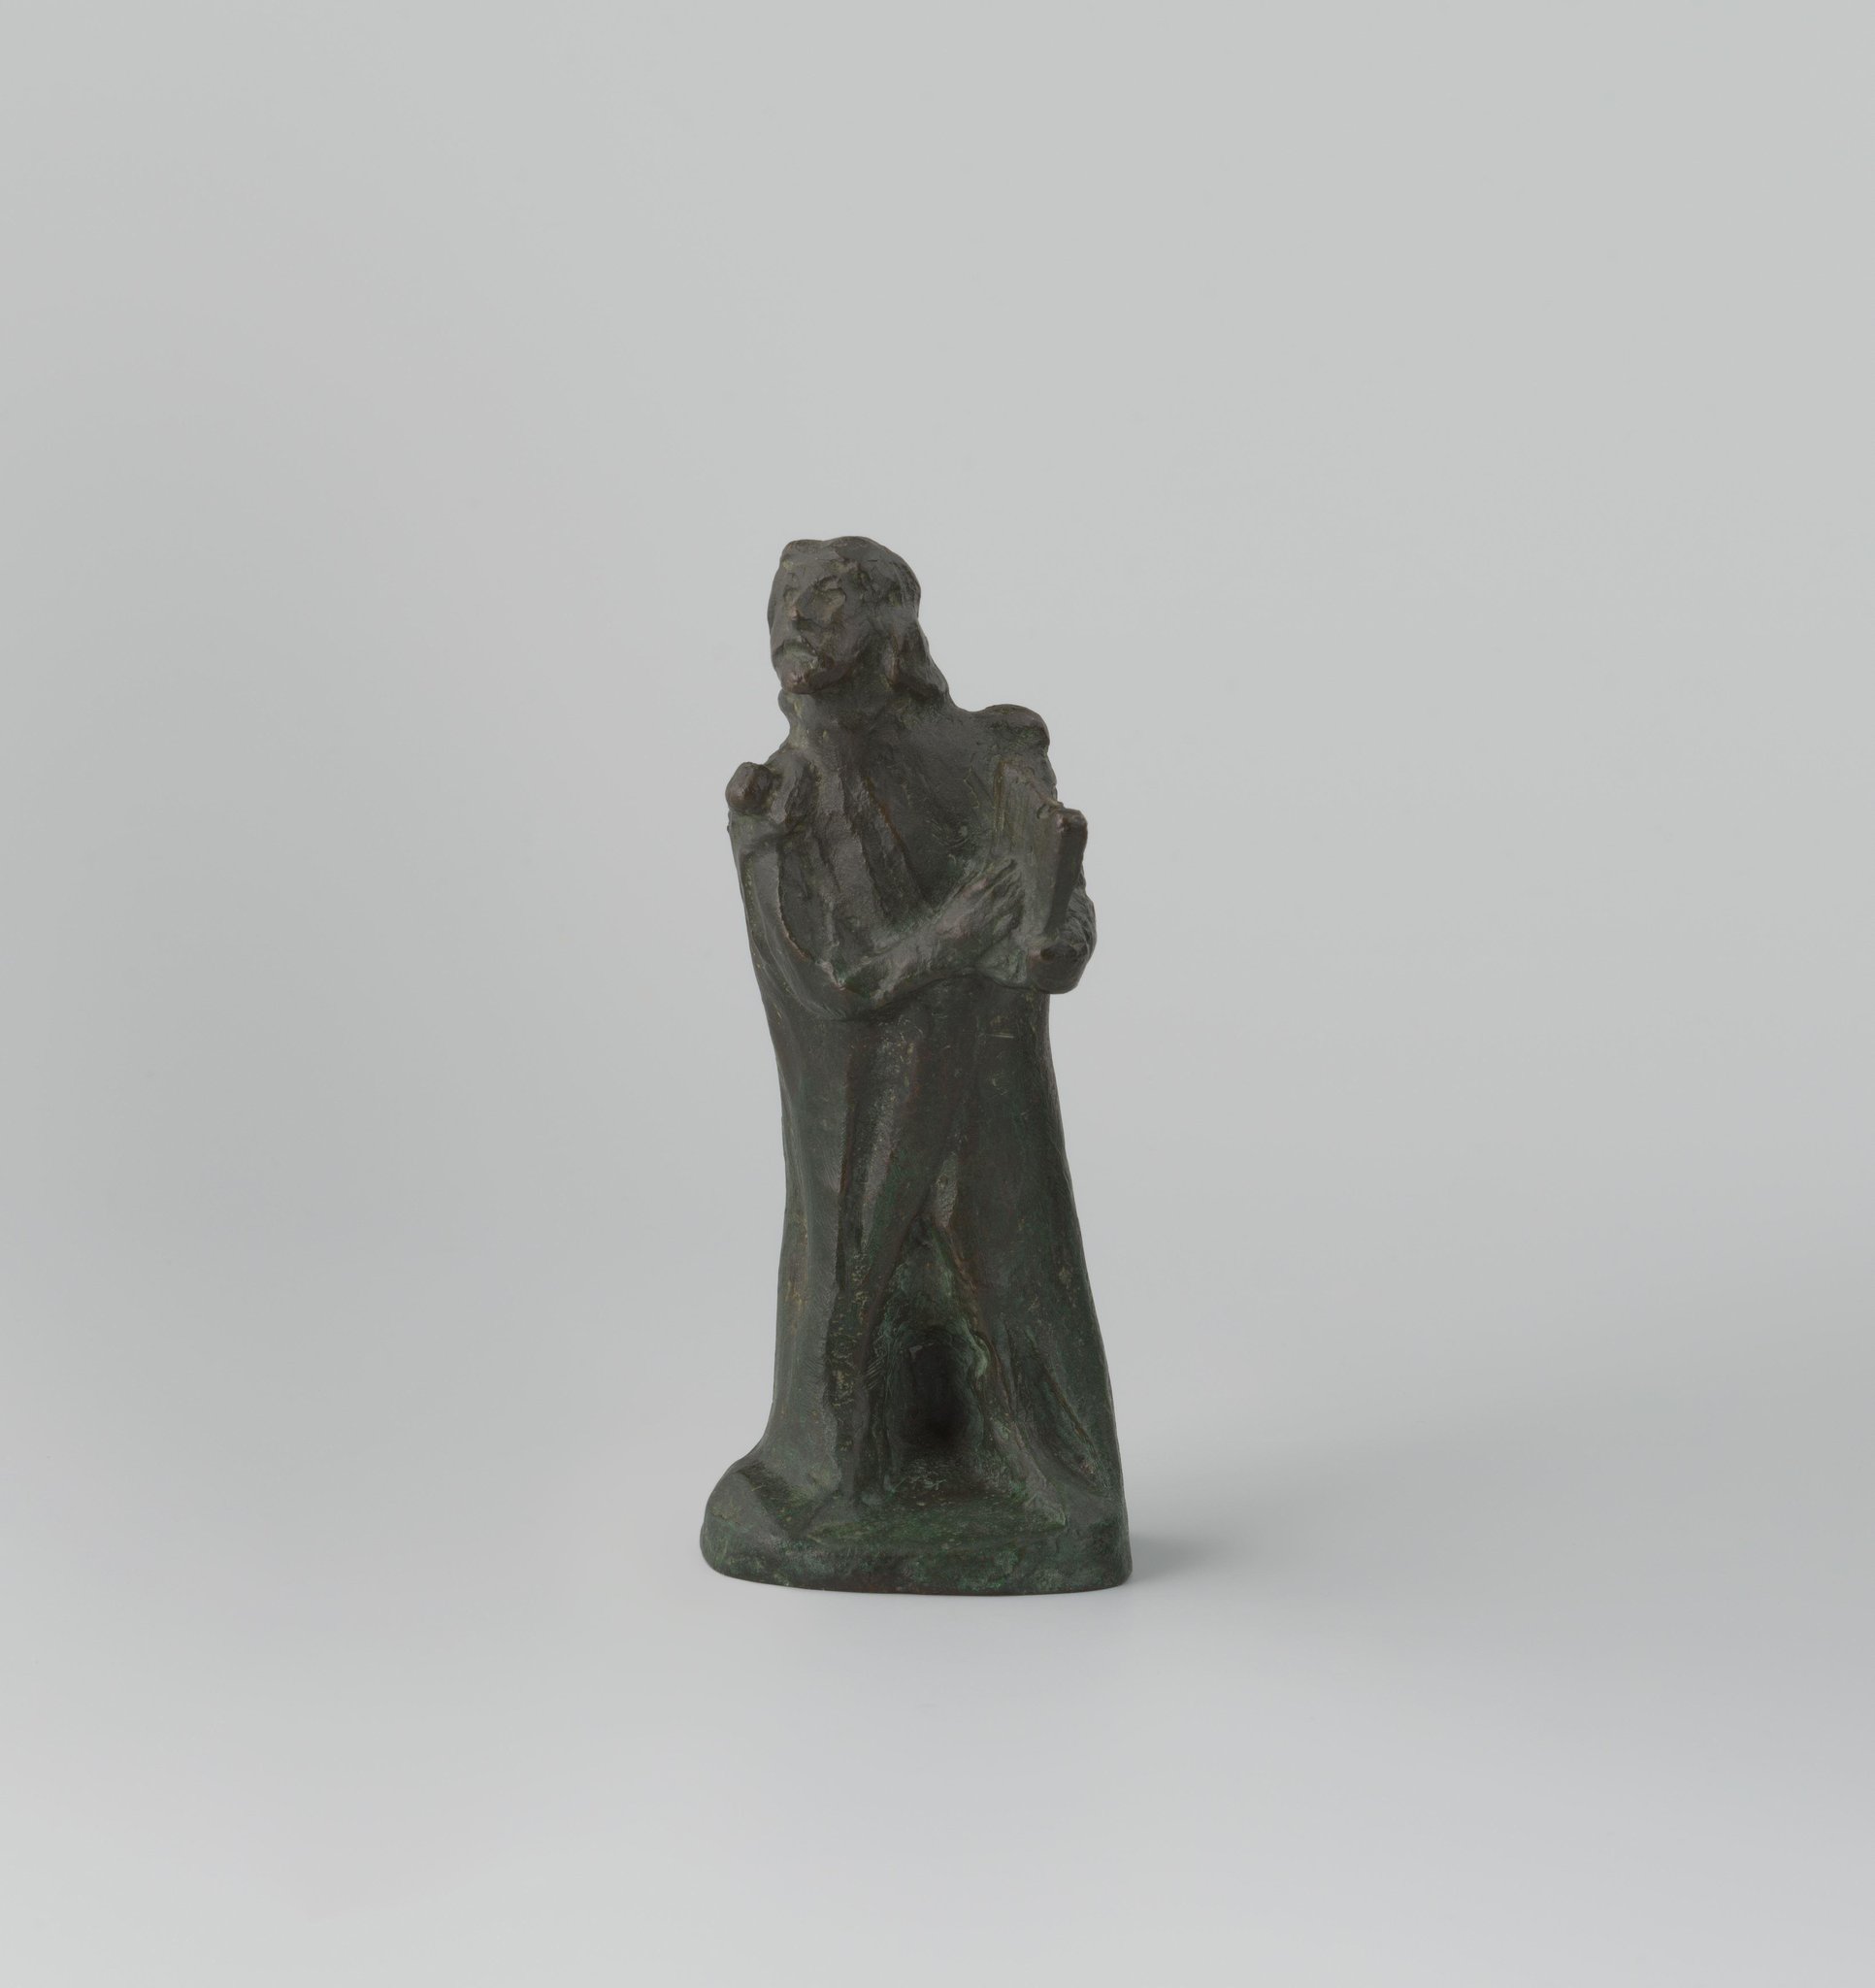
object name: chess piece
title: Pion 1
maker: saar de swart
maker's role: sculptor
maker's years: 1861-1951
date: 1923-1925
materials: bronze, oxide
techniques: casting, lost wax process, patinaed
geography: capri